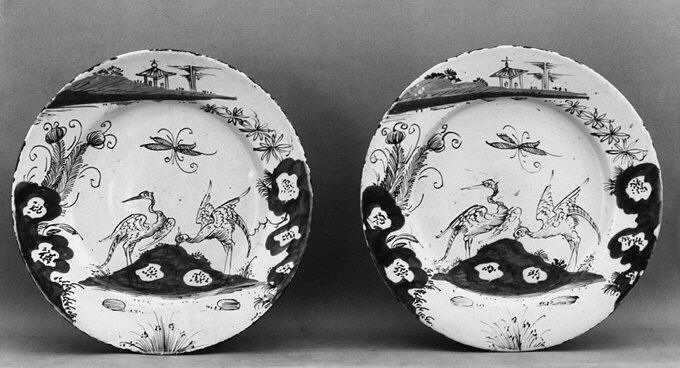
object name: plate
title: Plate (one of a pair)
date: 1701-1800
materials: earthenware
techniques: glazing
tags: birds,butterflies